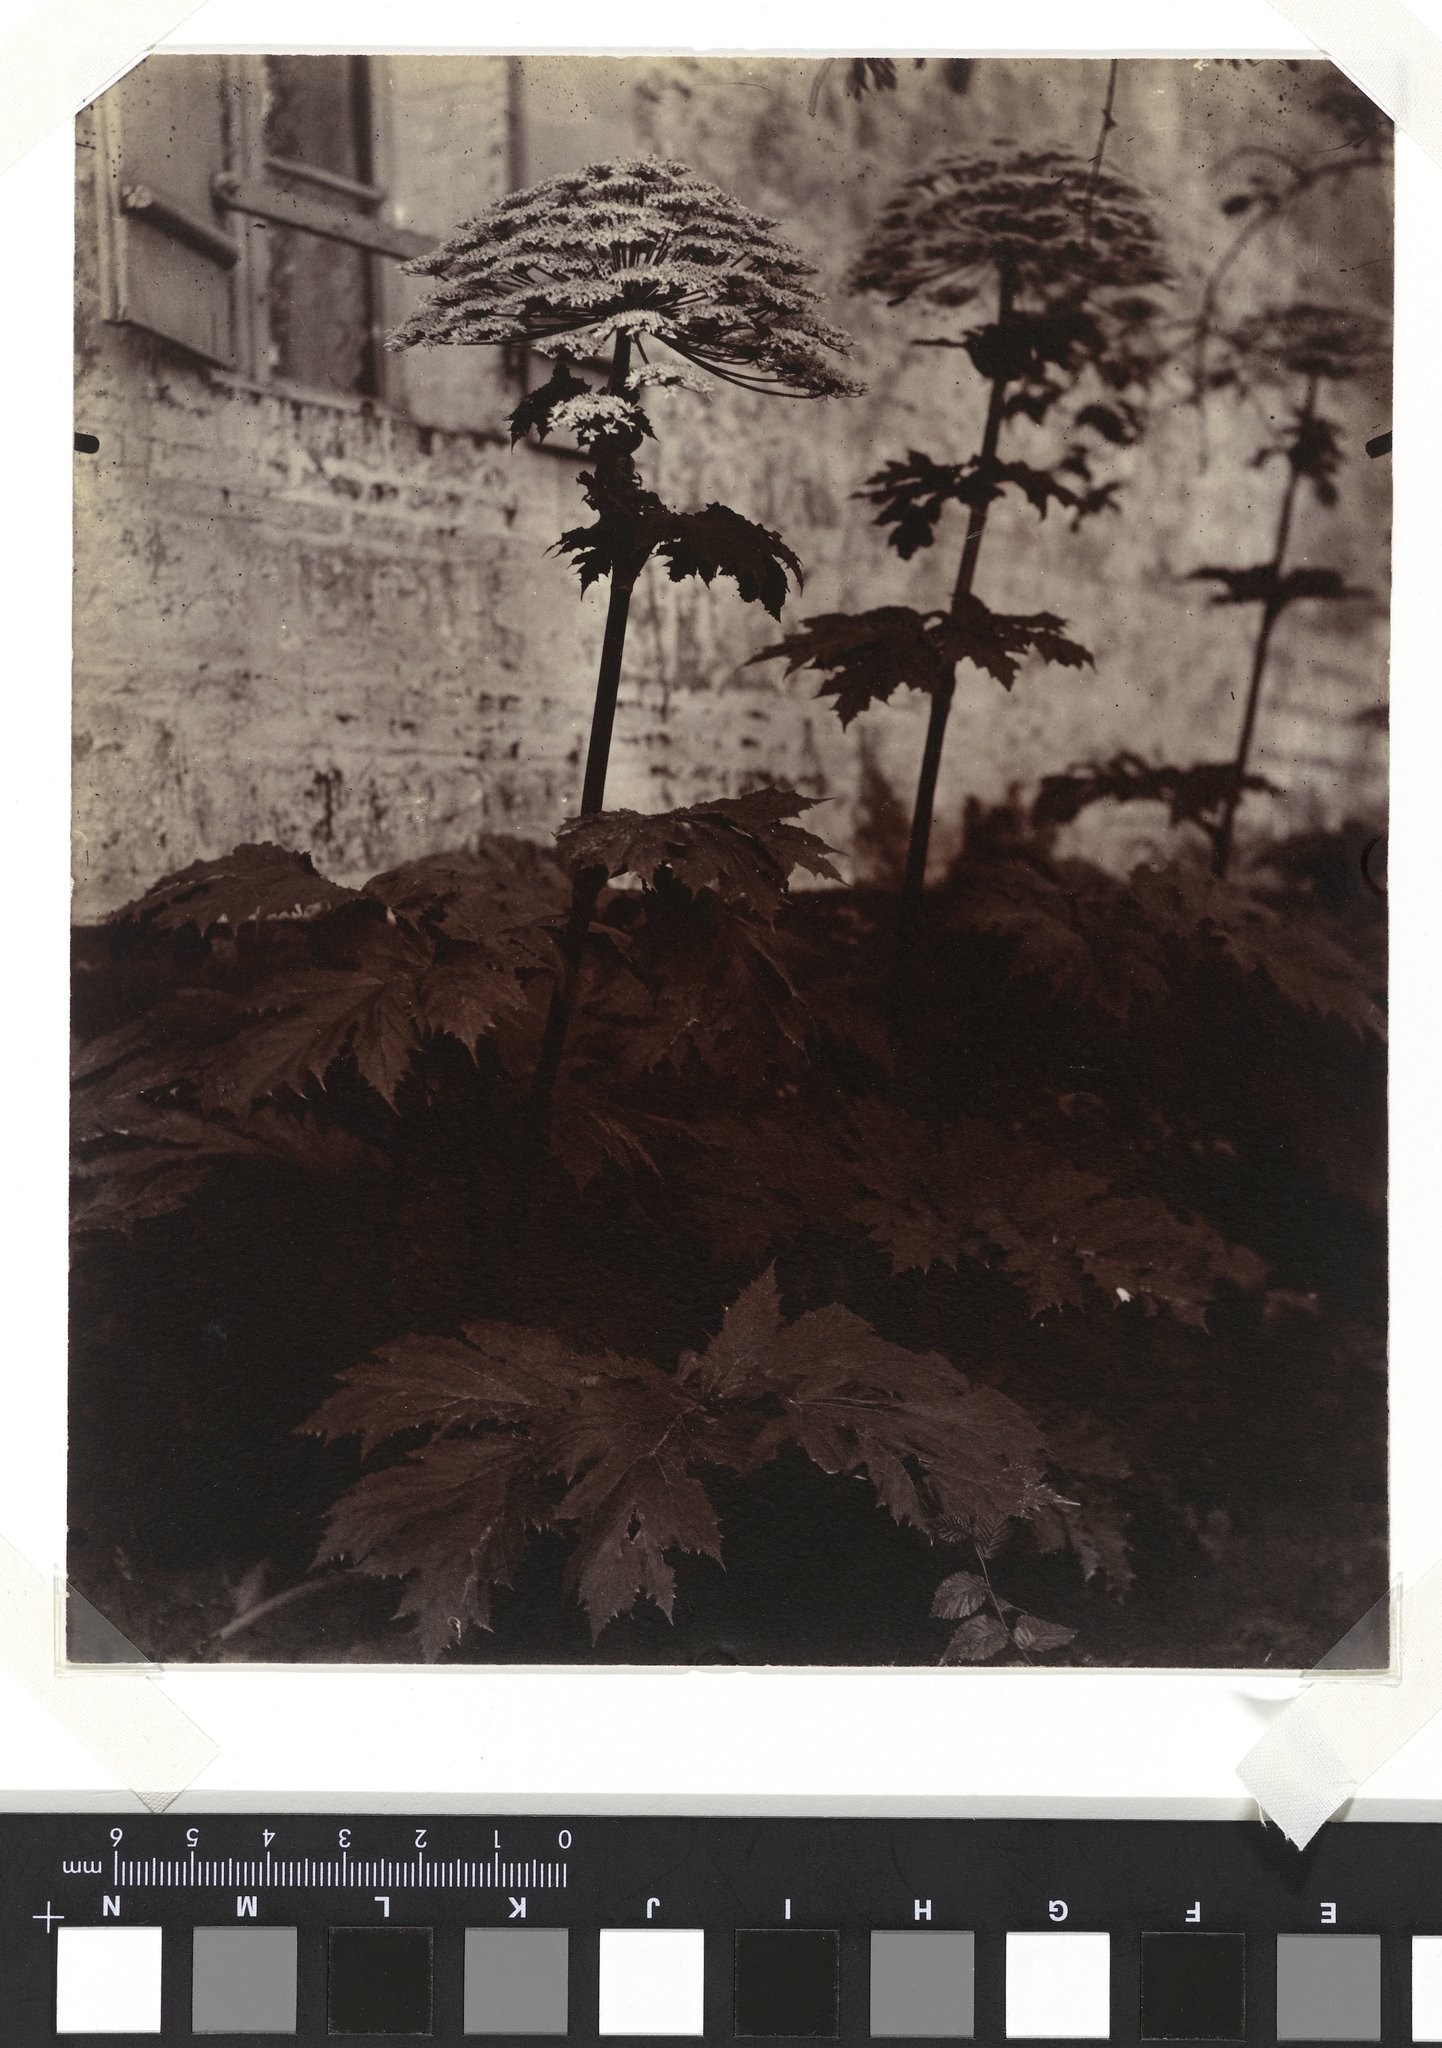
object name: photograph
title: Study of Plants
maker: eugène atget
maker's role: fotograaf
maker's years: 1857-1927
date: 1900-1910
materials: cardboard, paper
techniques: albumen print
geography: paris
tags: flowers, paris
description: Eugène Atget is one of the best-known photographers to document Paris in the 20th century. He photographed countless streets, interiors, lampposts, and other street furniture. Less known are his studies of plants – taken in and outside of Paris. After Atget’s death in 1927, his photographs of a vanished Paris secured his reputation as one of the most important and beloved figures in the history of photography.